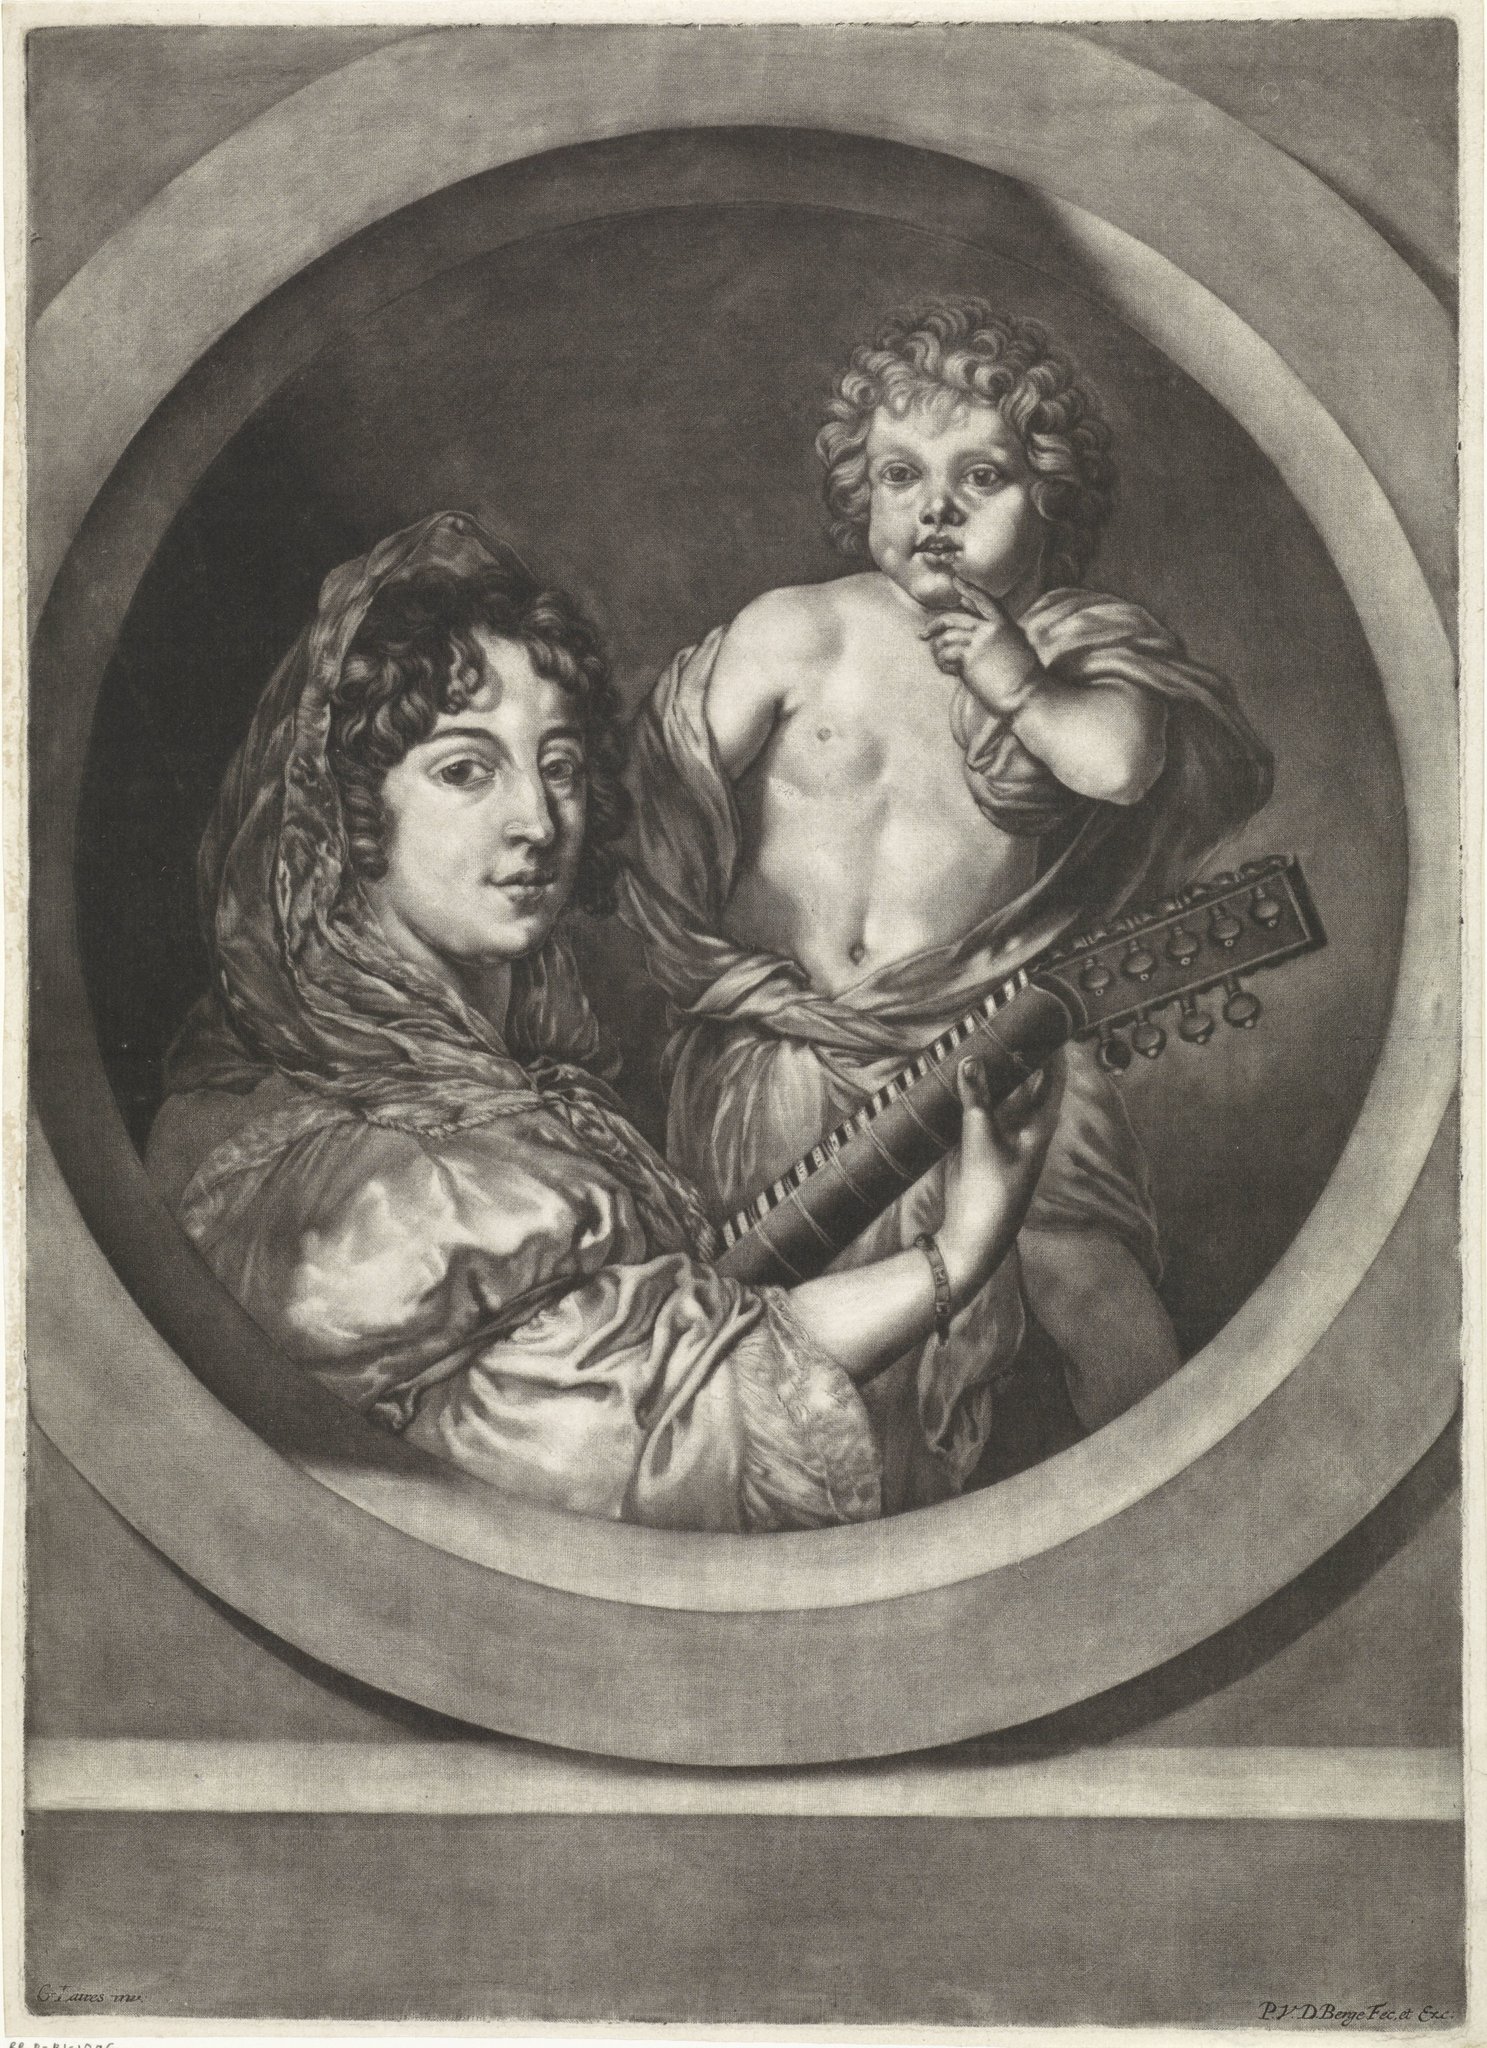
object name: print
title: Luitspeelster en kind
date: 1686-1737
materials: paper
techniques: engraving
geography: amsterdam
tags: one person playing string instrument (plucked), lute, and special forms of lute, e.g.: theorbo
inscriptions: collector's mark: Lugt 240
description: Luitspeelser en haar kind. De vrouw is mogelijk Maria Salme, de echtgenote van Gerard de Lairesse.